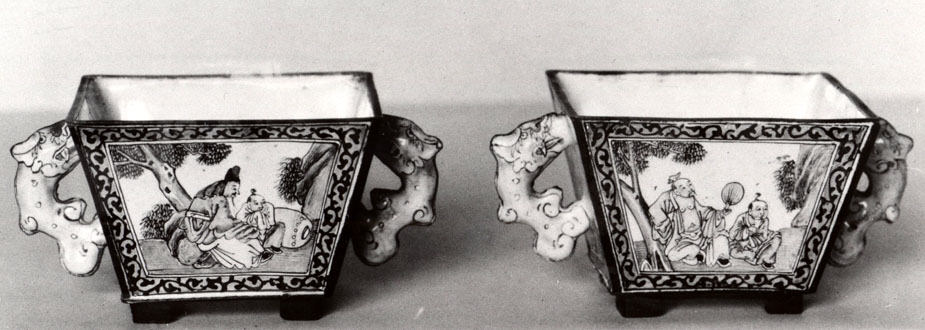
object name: cup with handle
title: Square Cup with Handle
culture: chinese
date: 1801-1900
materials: enamel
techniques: painting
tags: men,trees